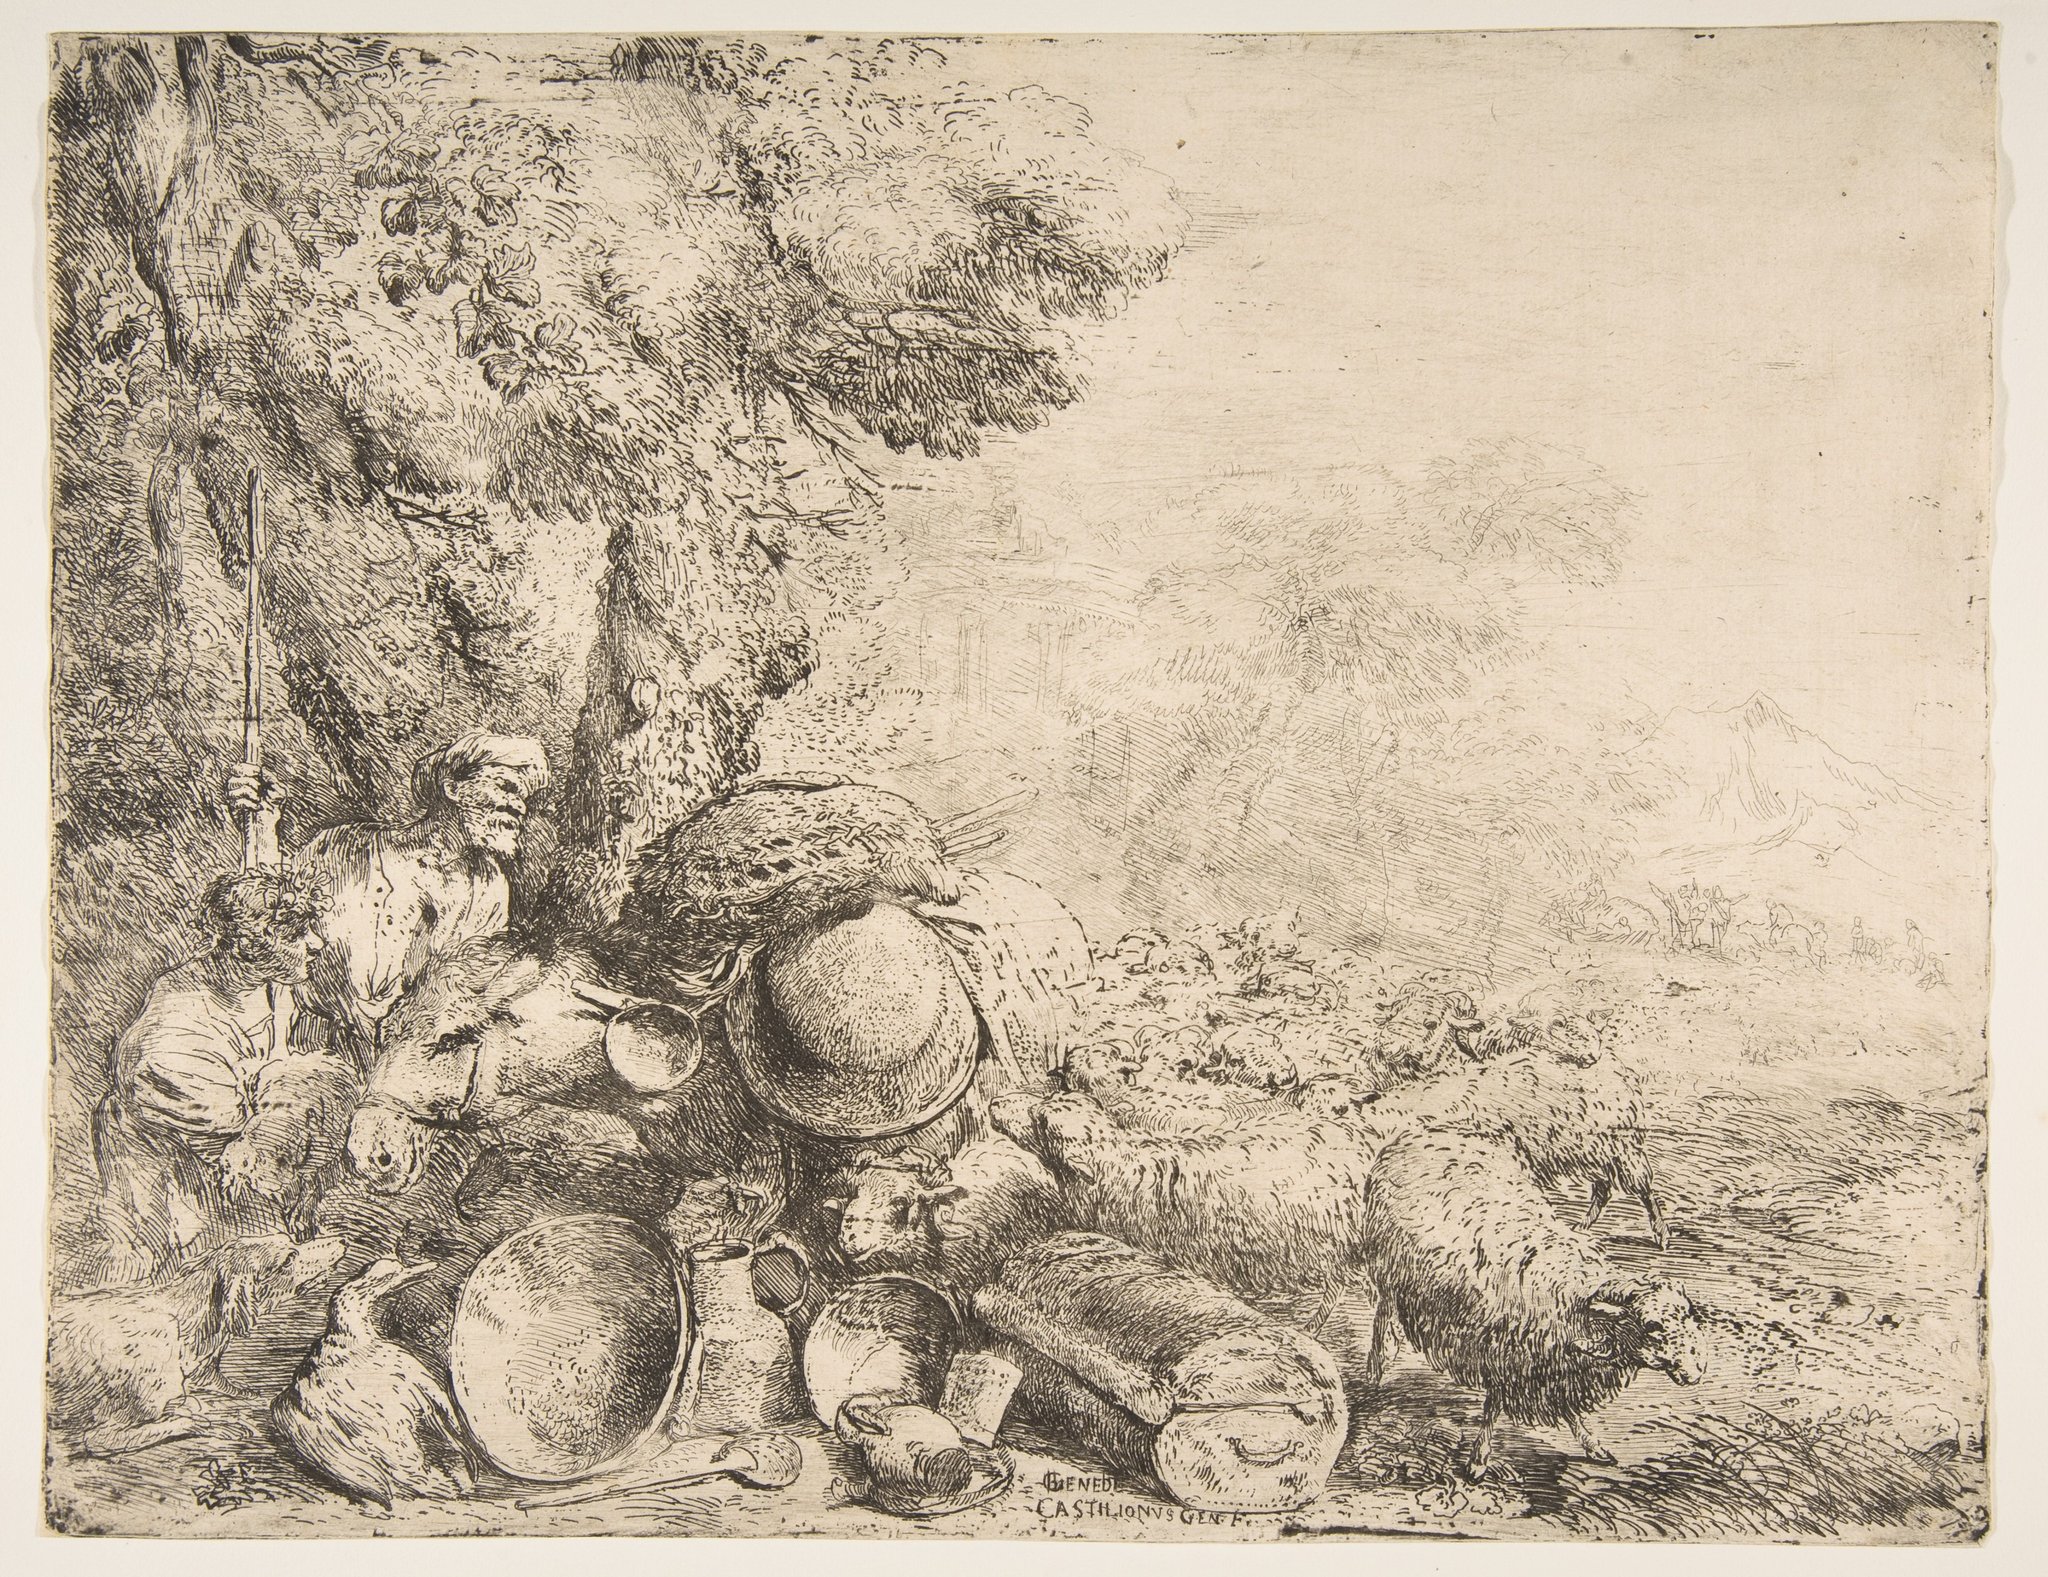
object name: print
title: Two shepherds, a donkey and other animals in a landscape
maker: giovanni benedetto castiglione (il grechetto)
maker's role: artist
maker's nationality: italian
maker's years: 1609-1664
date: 1638-1640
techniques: etching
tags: men,donkeys,sheep,shepherds